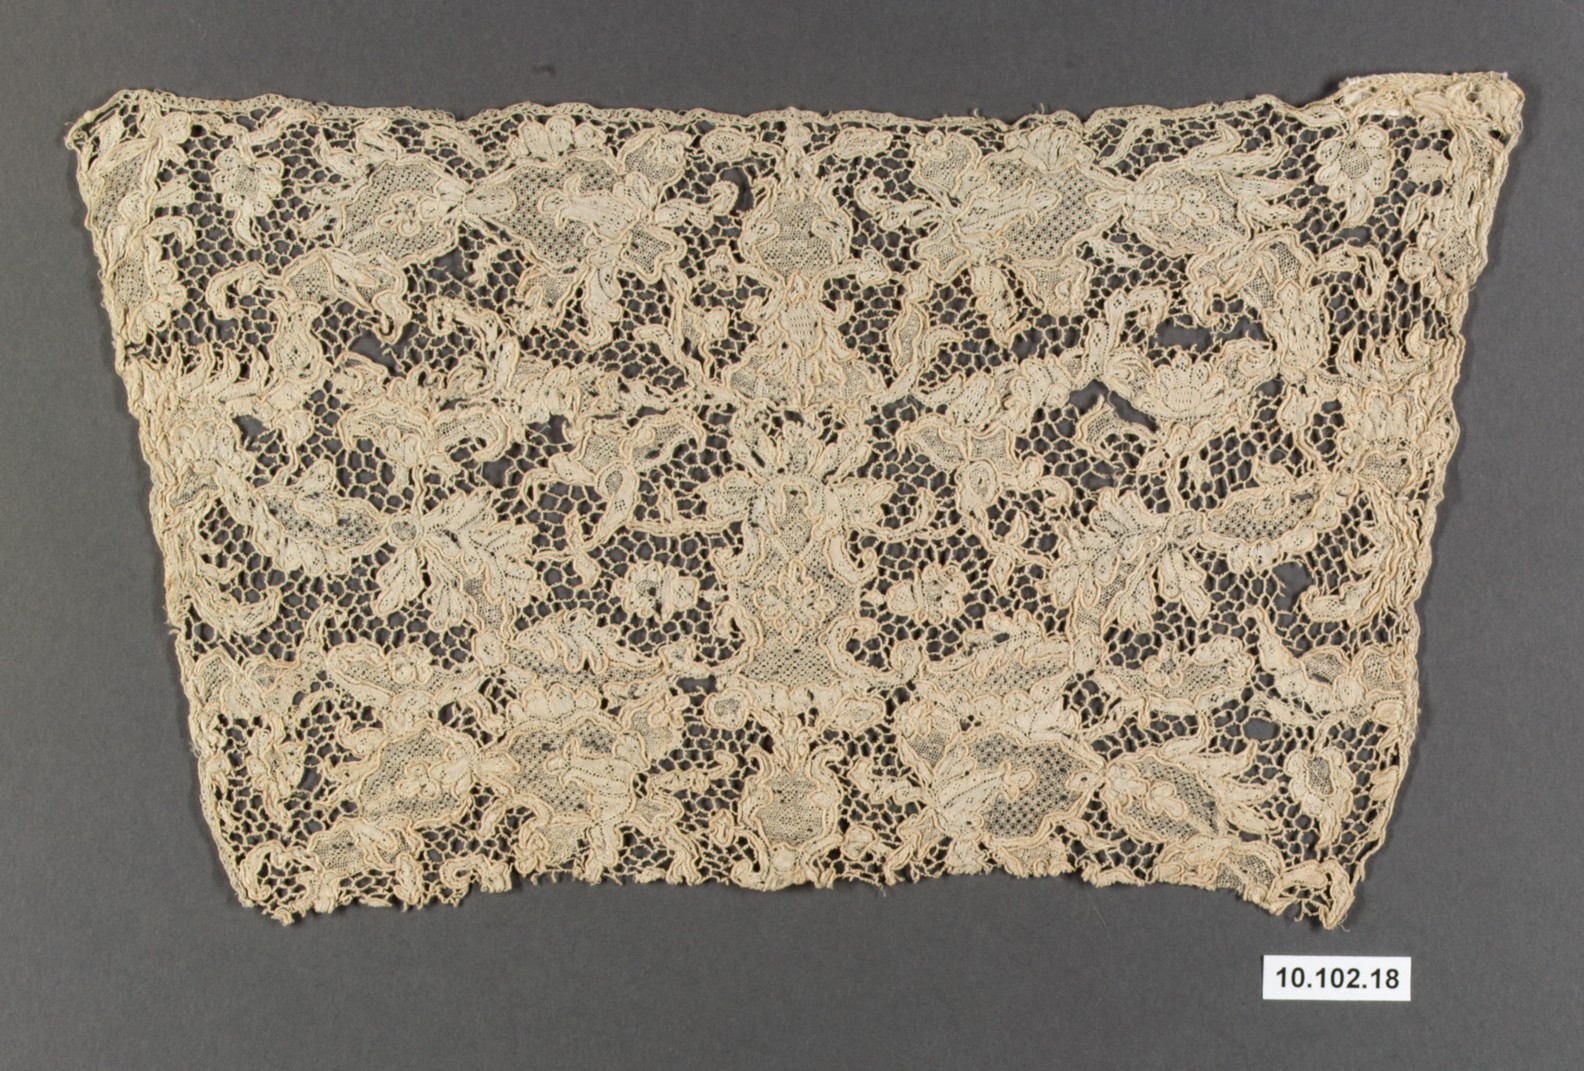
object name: fragment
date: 1701-1800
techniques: lace